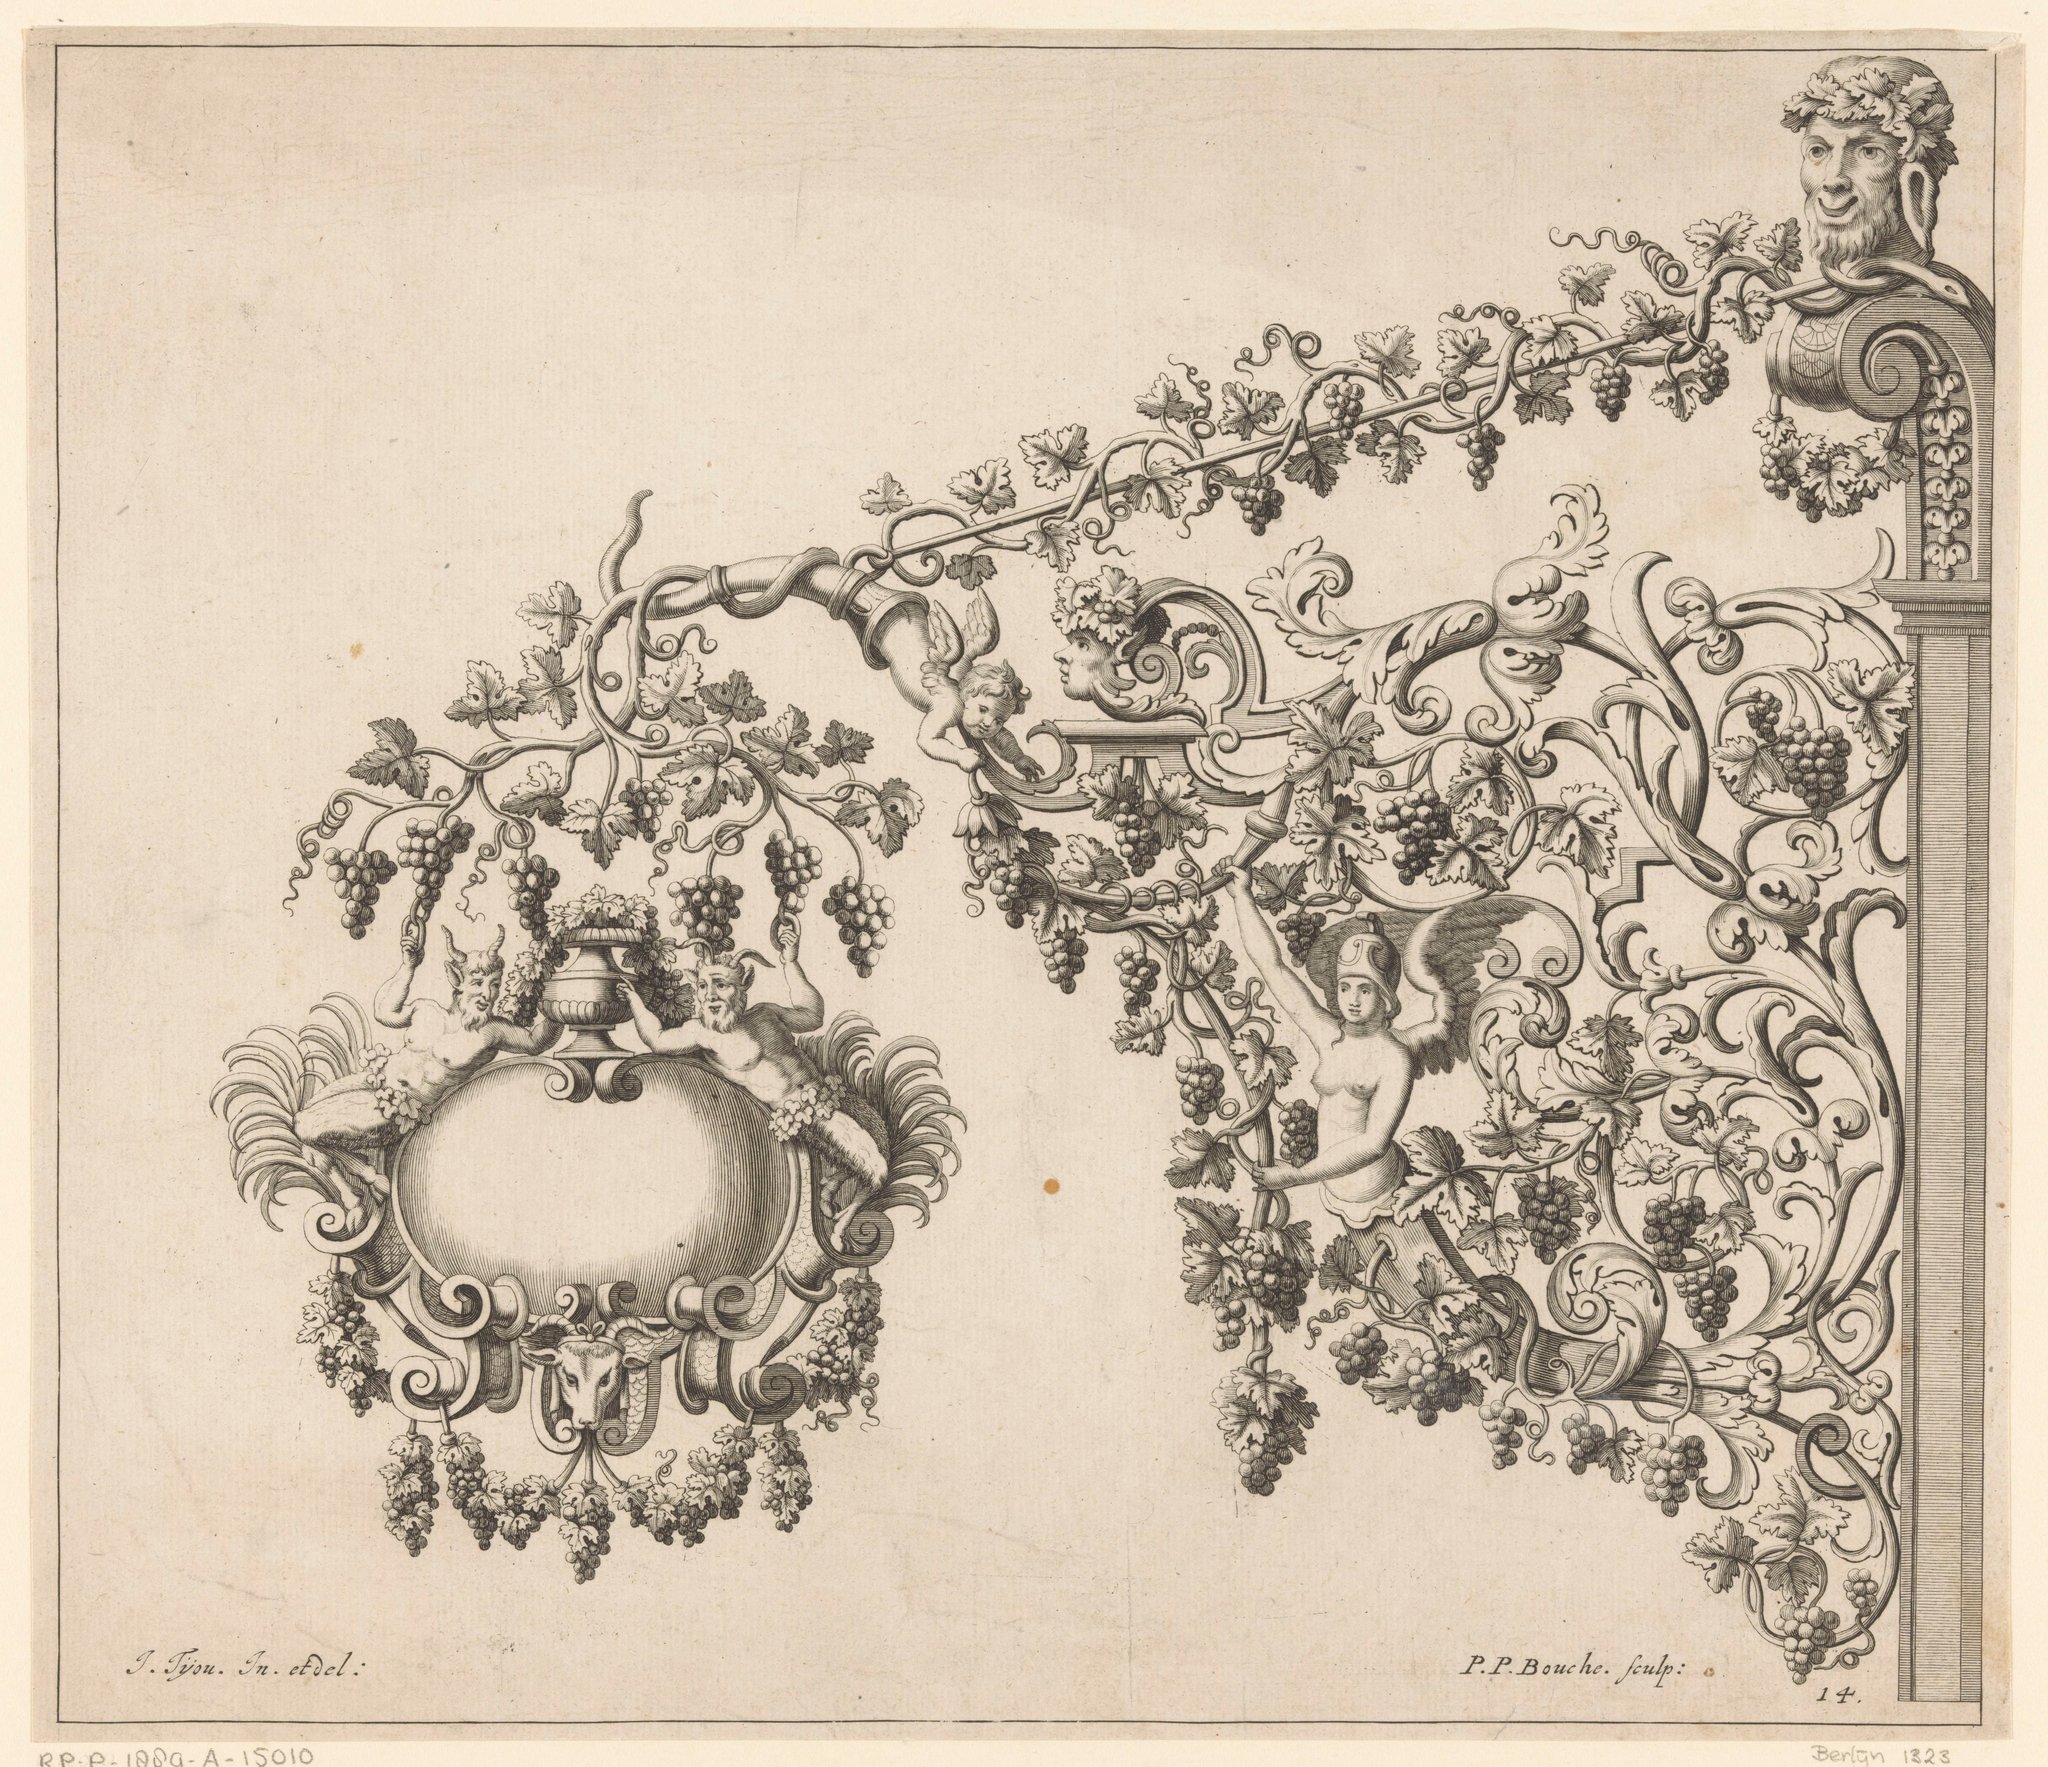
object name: print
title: Nouueau liure de Desseins (...) / A New Booke of Drawing (...)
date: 1693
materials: paper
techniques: engraving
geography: london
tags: vine-tendril, leaf, satyr(s) (in general), signboard, cupids: 'amores', 'amoretti', 'putti'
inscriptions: collector's mark: Lugt 2228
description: Een ontwerp voor een in ijzer te drijven uithangteken voor een wijnhandelaar. Gedecoreerd met saters en een putto temidden van druivenranken. Rechts onder 14 genummerd.